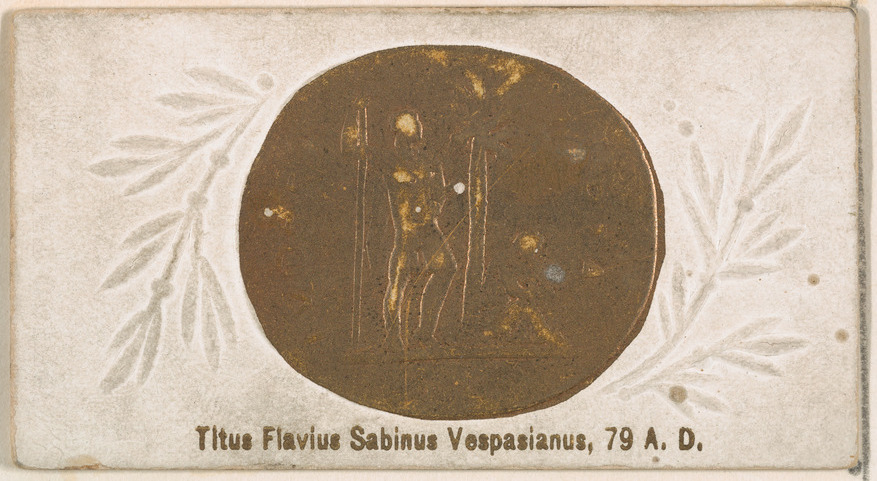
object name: print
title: Titus Flavius Savinus Vespasianus, 79 A.D., from the Ancient Coins series (N180) issued by Wm. S. Kimball & Co.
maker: william s. kimball & company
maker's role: publisher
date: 1888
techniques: color lithograph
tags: coins